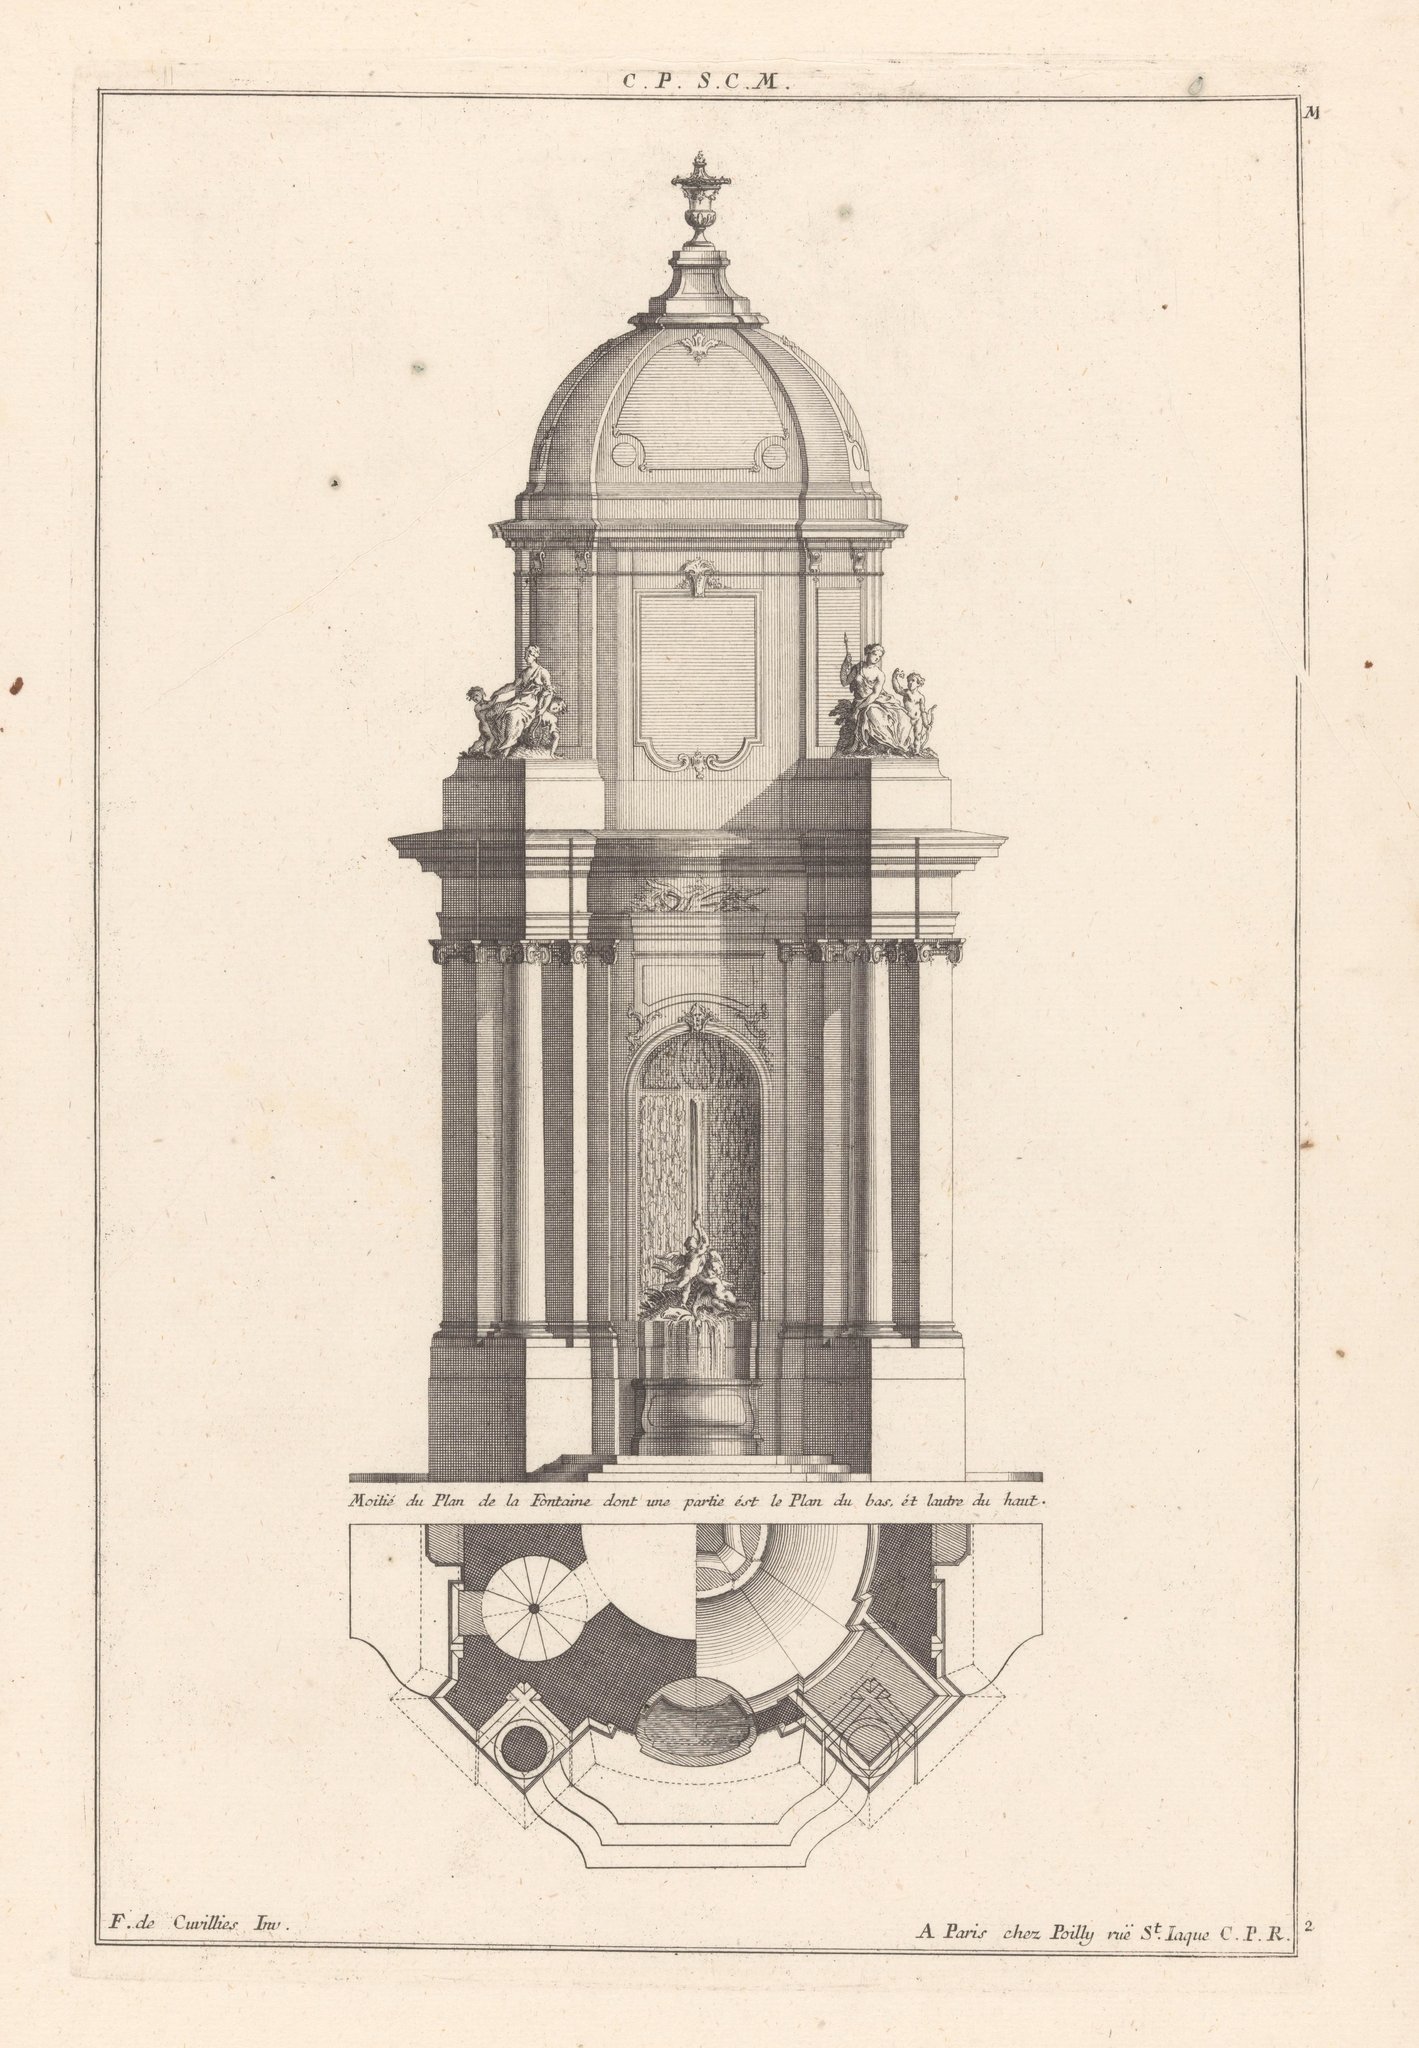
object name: ornament print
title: Fontein met vrouwen en putti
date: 1745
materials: paper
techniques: engraving, etching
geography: germany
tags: sitting figure - aa - female human figure, other architectural details (cupola), ornamental fountain, cupids: 'amores', 'amoretti', 'putti'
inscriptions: collector's mark: Lugt 2228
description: Ontwerp en plattegrond van een fontein met een koepel en putti, aan de bovenzijde twee zittende vrouwen met putti.